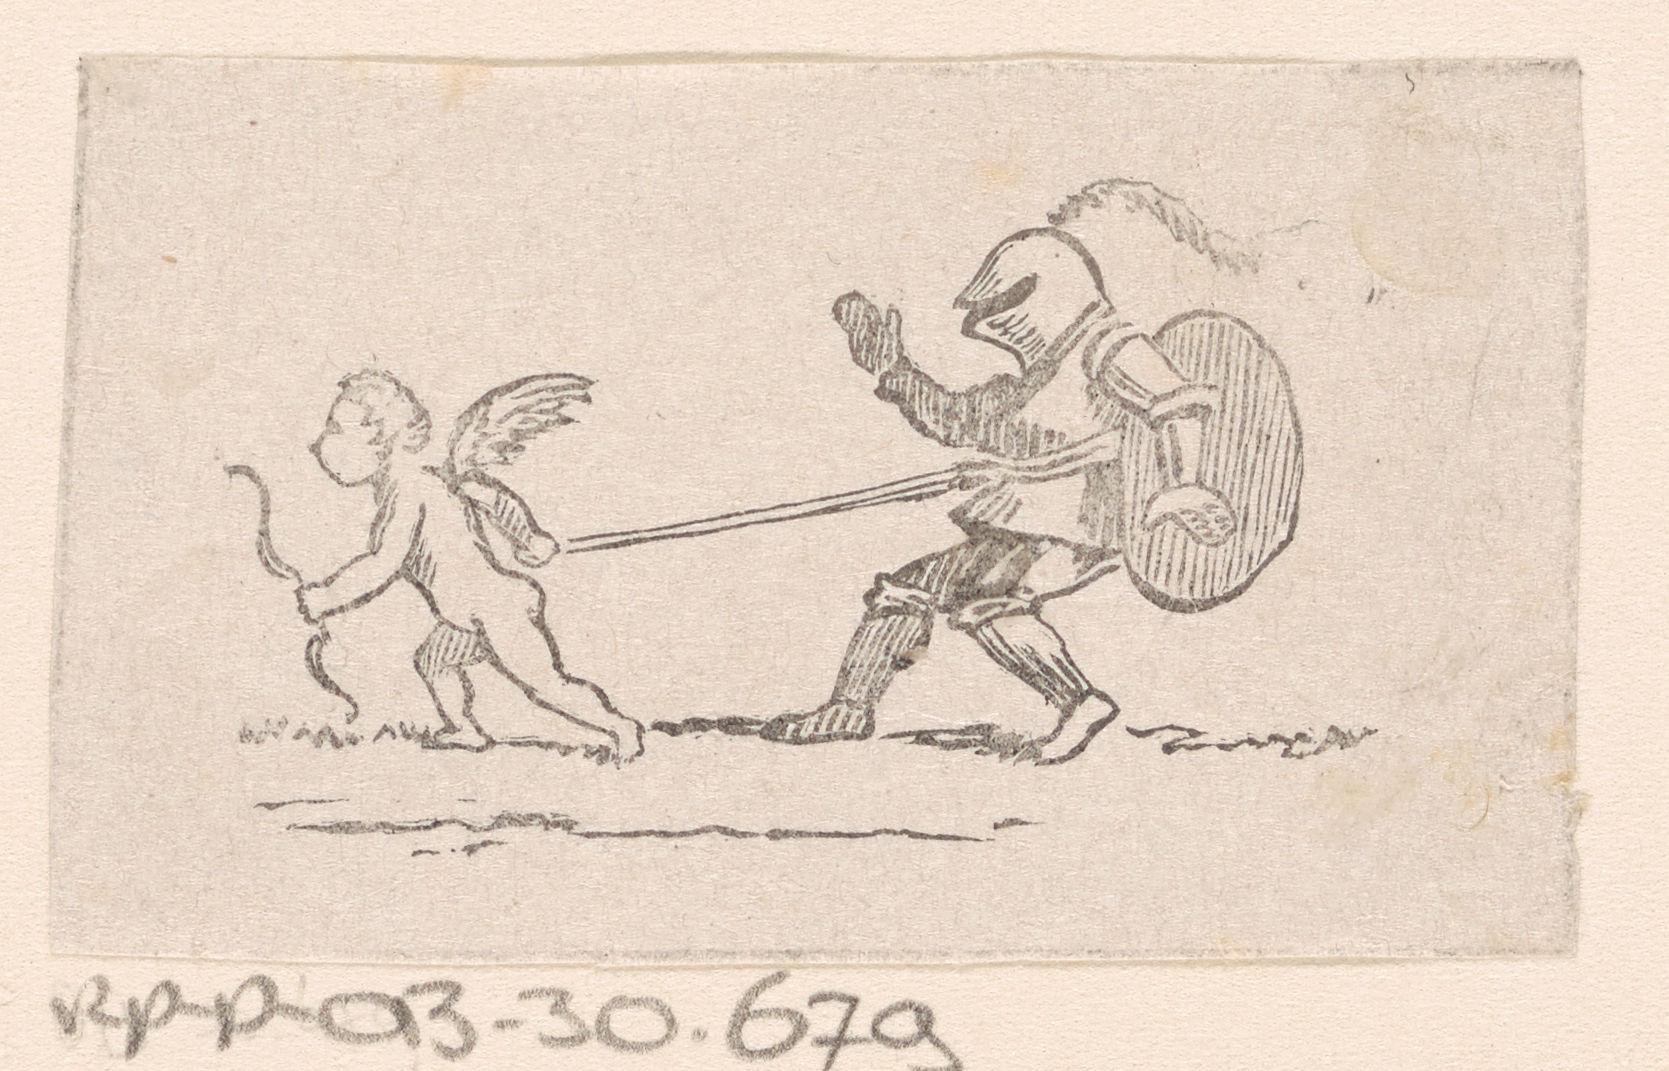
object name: print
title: Cupido een ridder aan een touw meetrekkend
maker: isaac weissenbruch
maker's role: print maker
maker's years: 1826-1912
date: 1836-1912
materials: paper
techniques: engraving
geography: netherlands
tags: (story of) cupid, amor (eros), knight